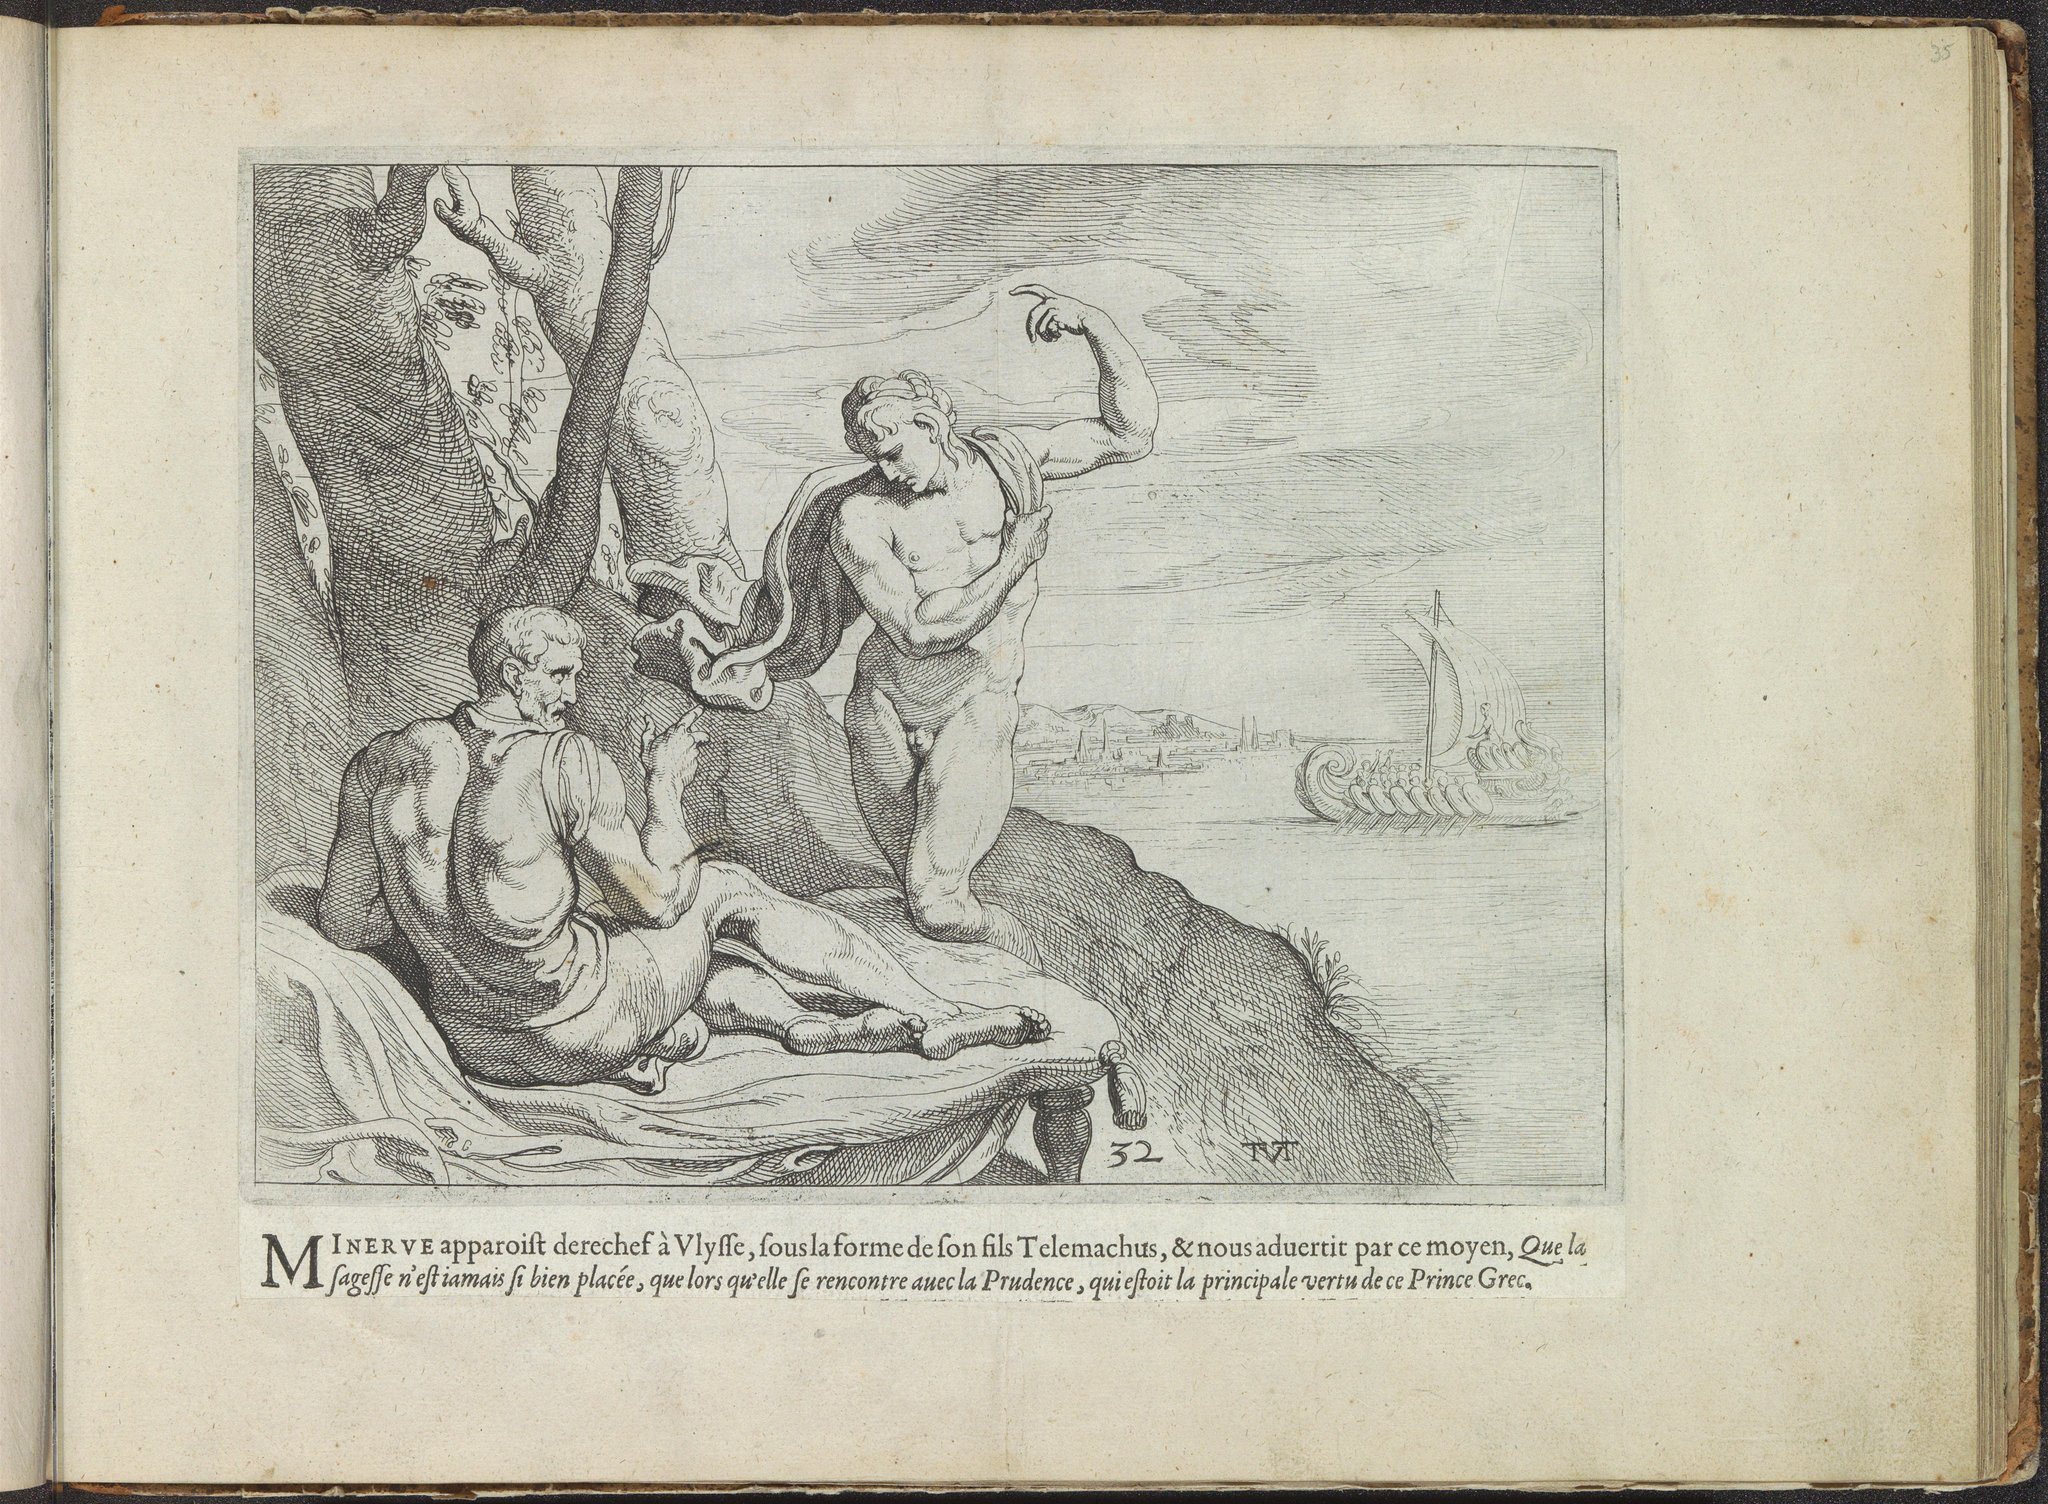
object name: album leaf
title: Minerva verschijnt in de gedaante van Telemachus aan Odysseus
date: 1633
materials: paper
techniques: engraving, etching, letterpress printing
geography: paris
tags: the seer theoclymenus joins telemachus' party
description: Minerva verschijnt in de gedaante van een jonge prins of Telemachus aan Odysseus. De prent maakt deel uit van een album.